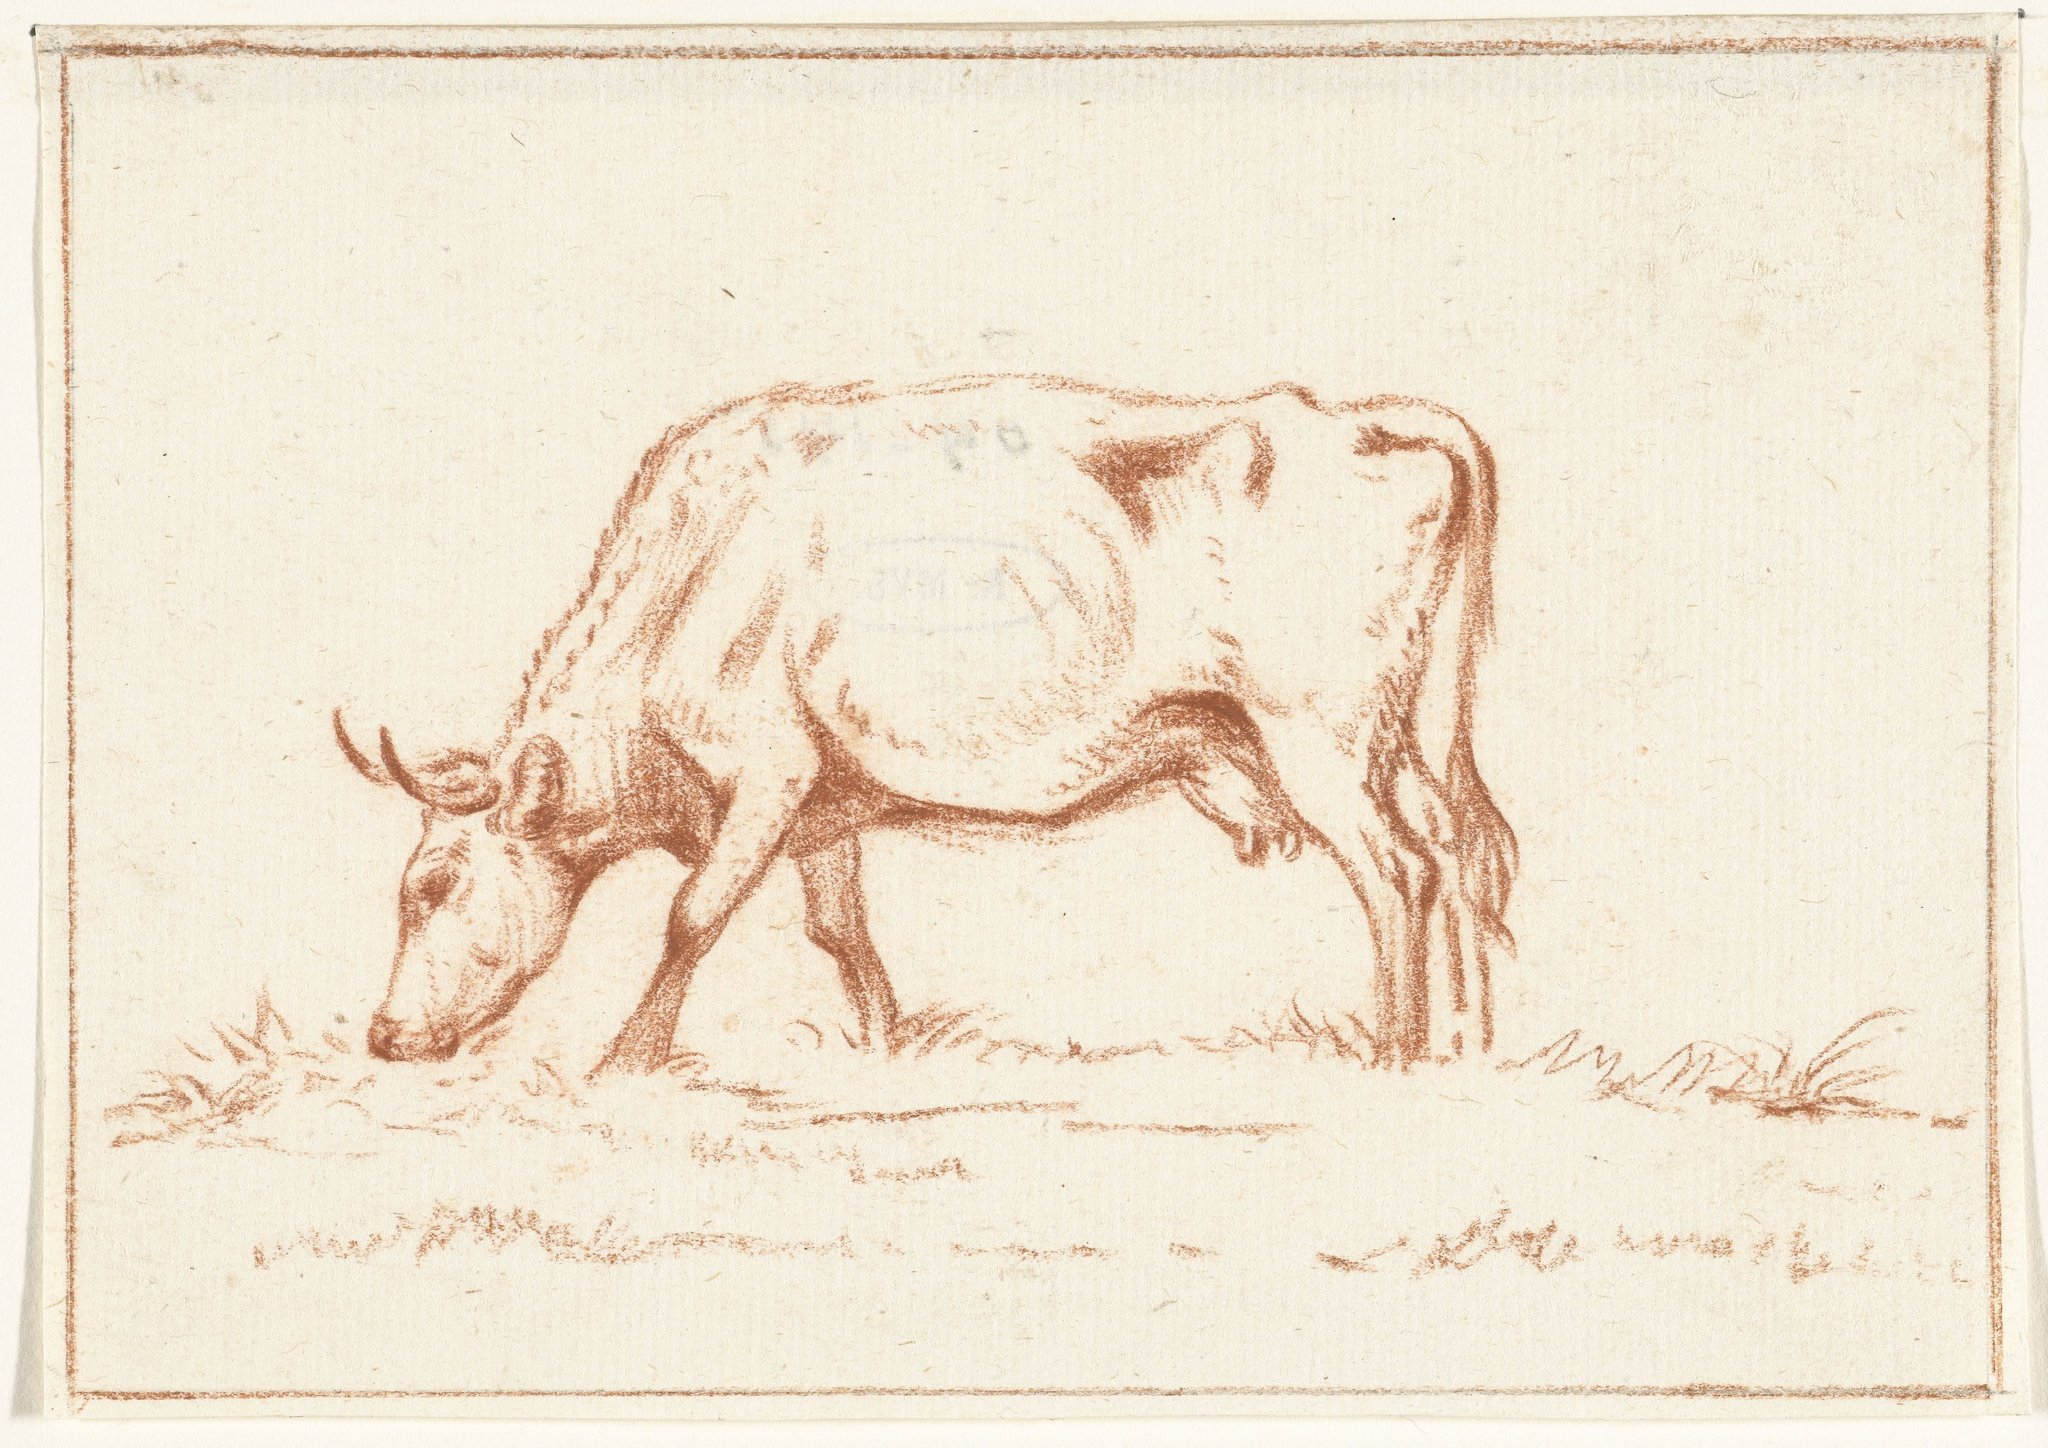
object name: drawing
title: Grazende koe, naar links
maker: jean bernard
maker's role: draughtsman, print maker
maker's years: 1765-1833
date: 1775-1833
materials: chalk, paper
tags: cow